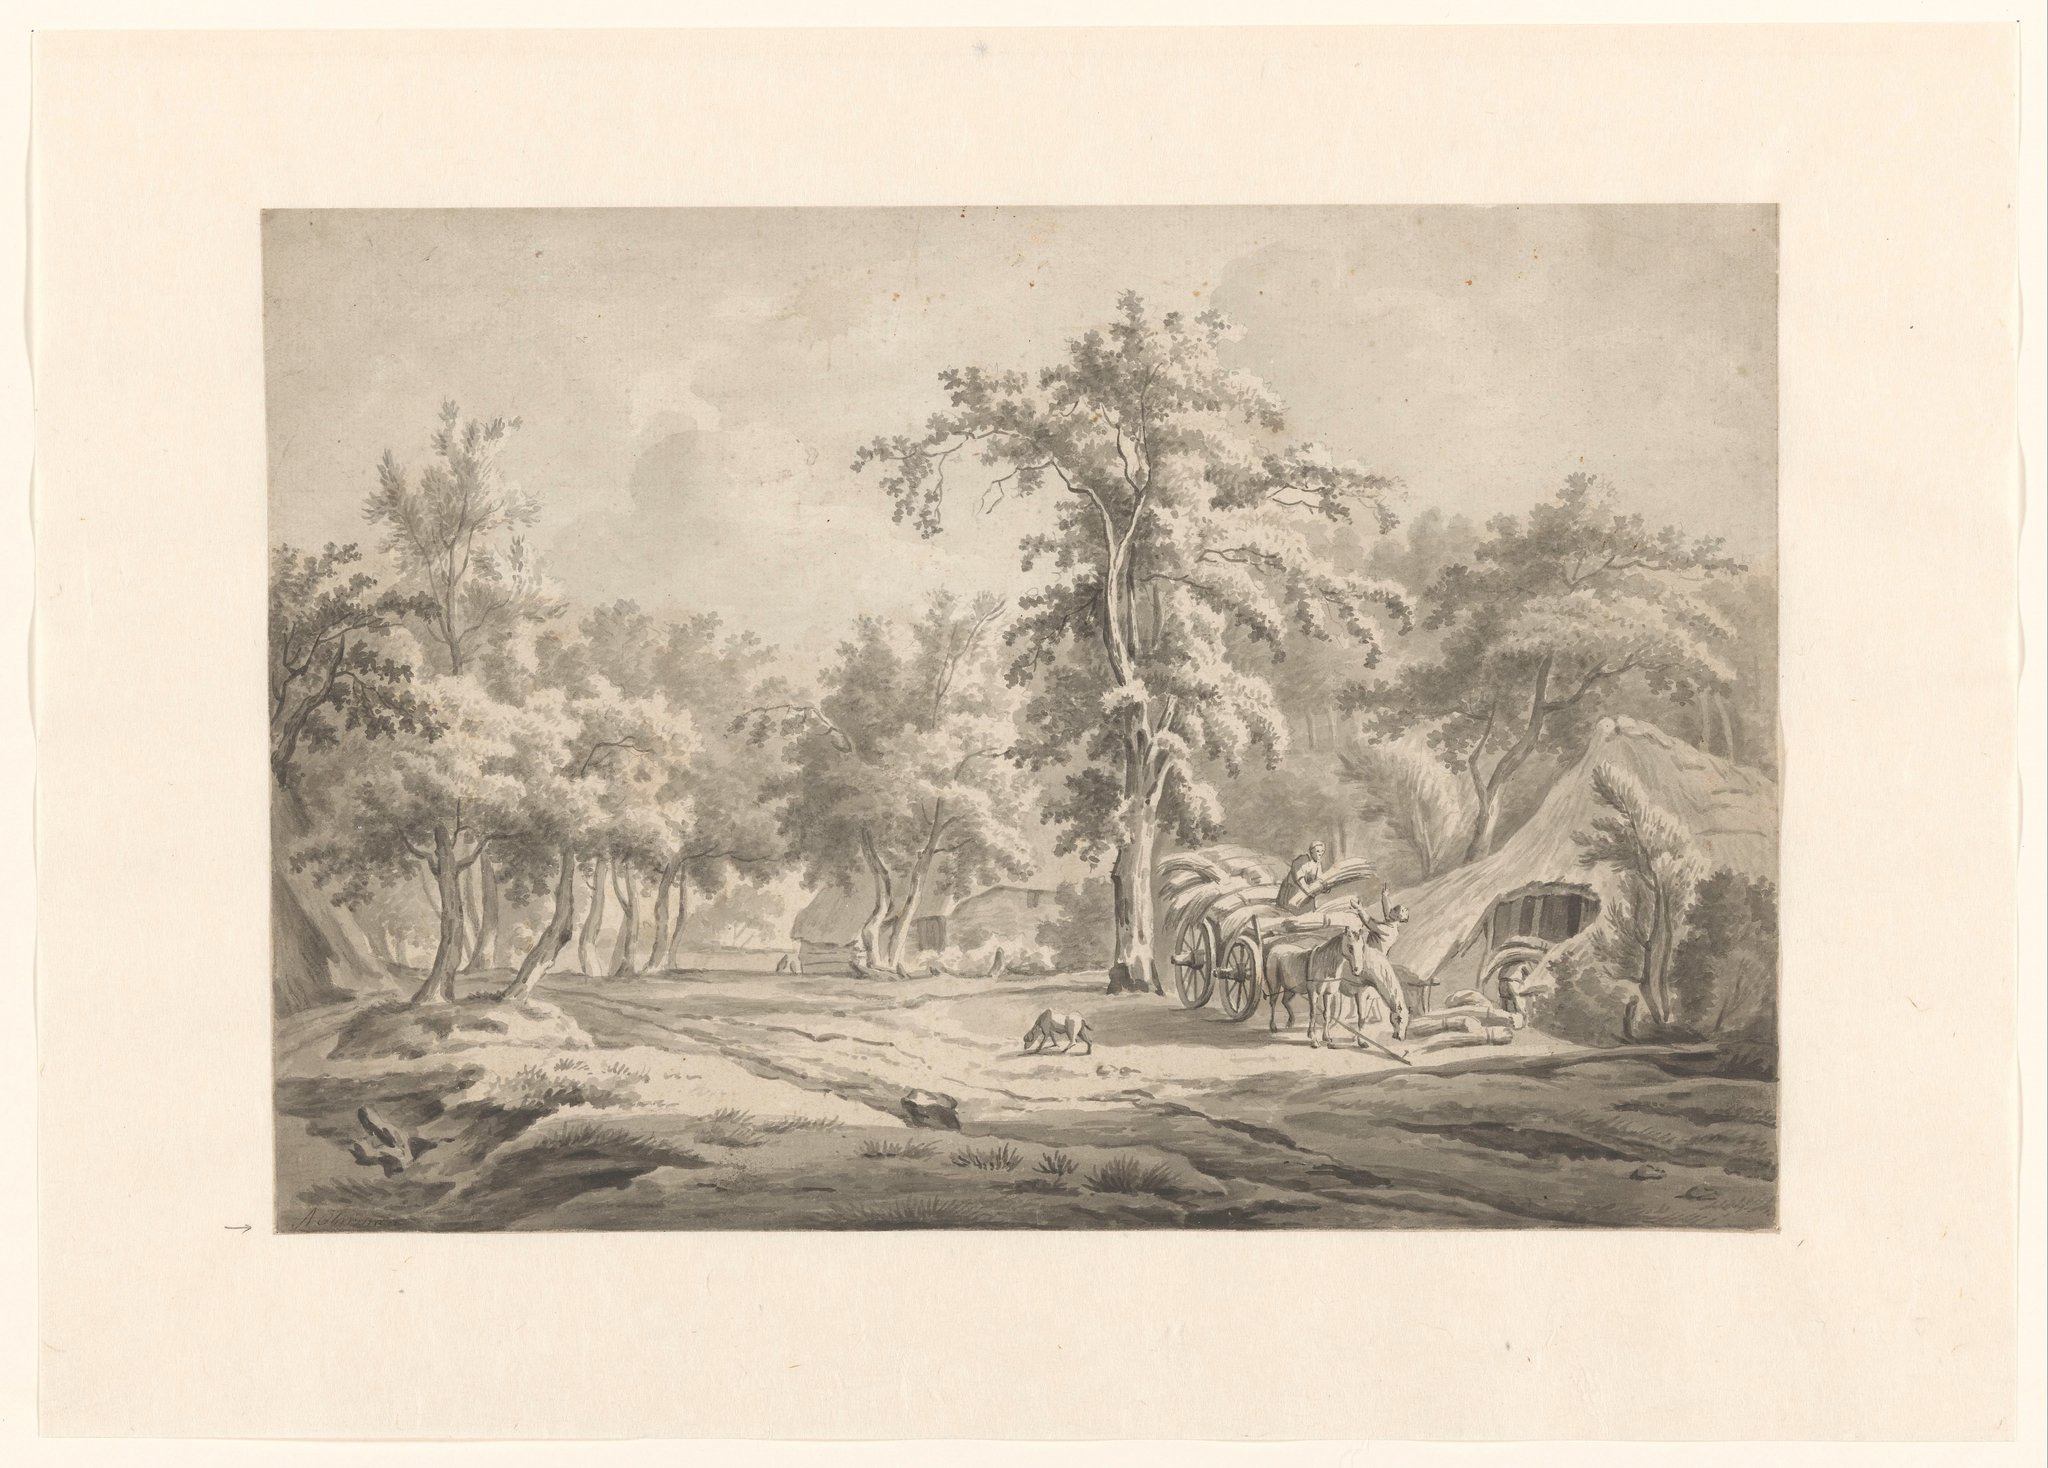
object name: drawing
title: Landweg met boerenhoeven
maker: Anonymous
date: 1800-1900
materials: paper, pencil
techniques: brush